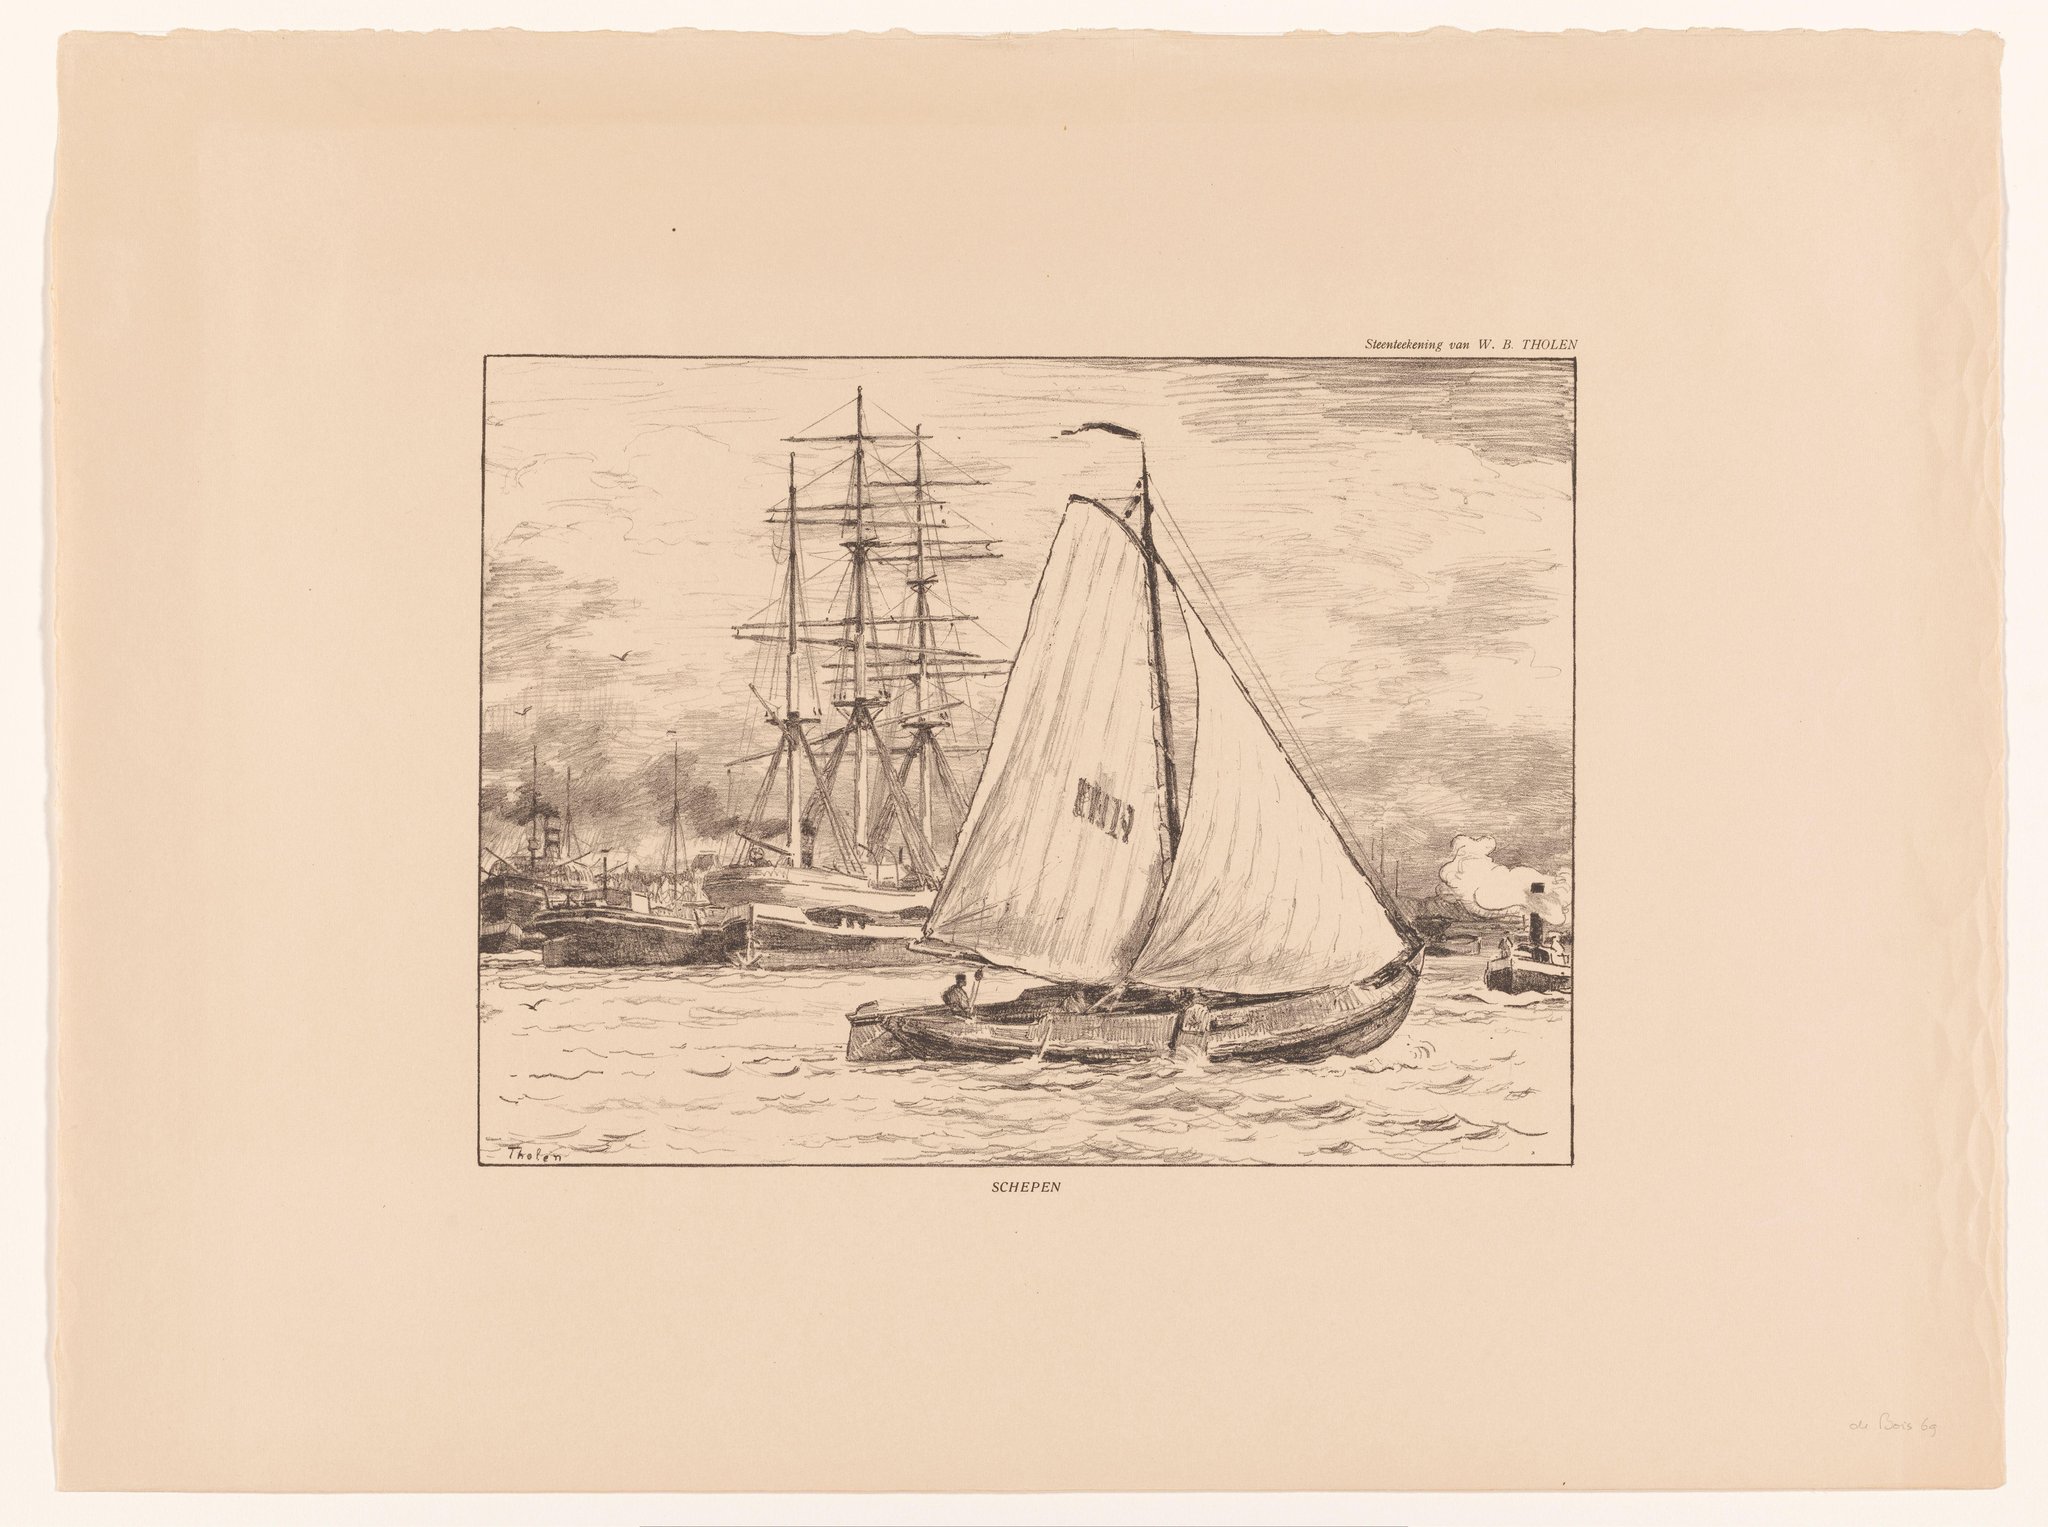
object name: print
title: Schepen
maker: willem bastiaan tholen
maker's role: draughtsman, painter, print maker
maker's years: 1860-1931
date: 1870-1931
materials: paper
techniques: lithograph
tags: sailing-ship, sailing-boat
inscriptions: collector's mark: Lugt 2228